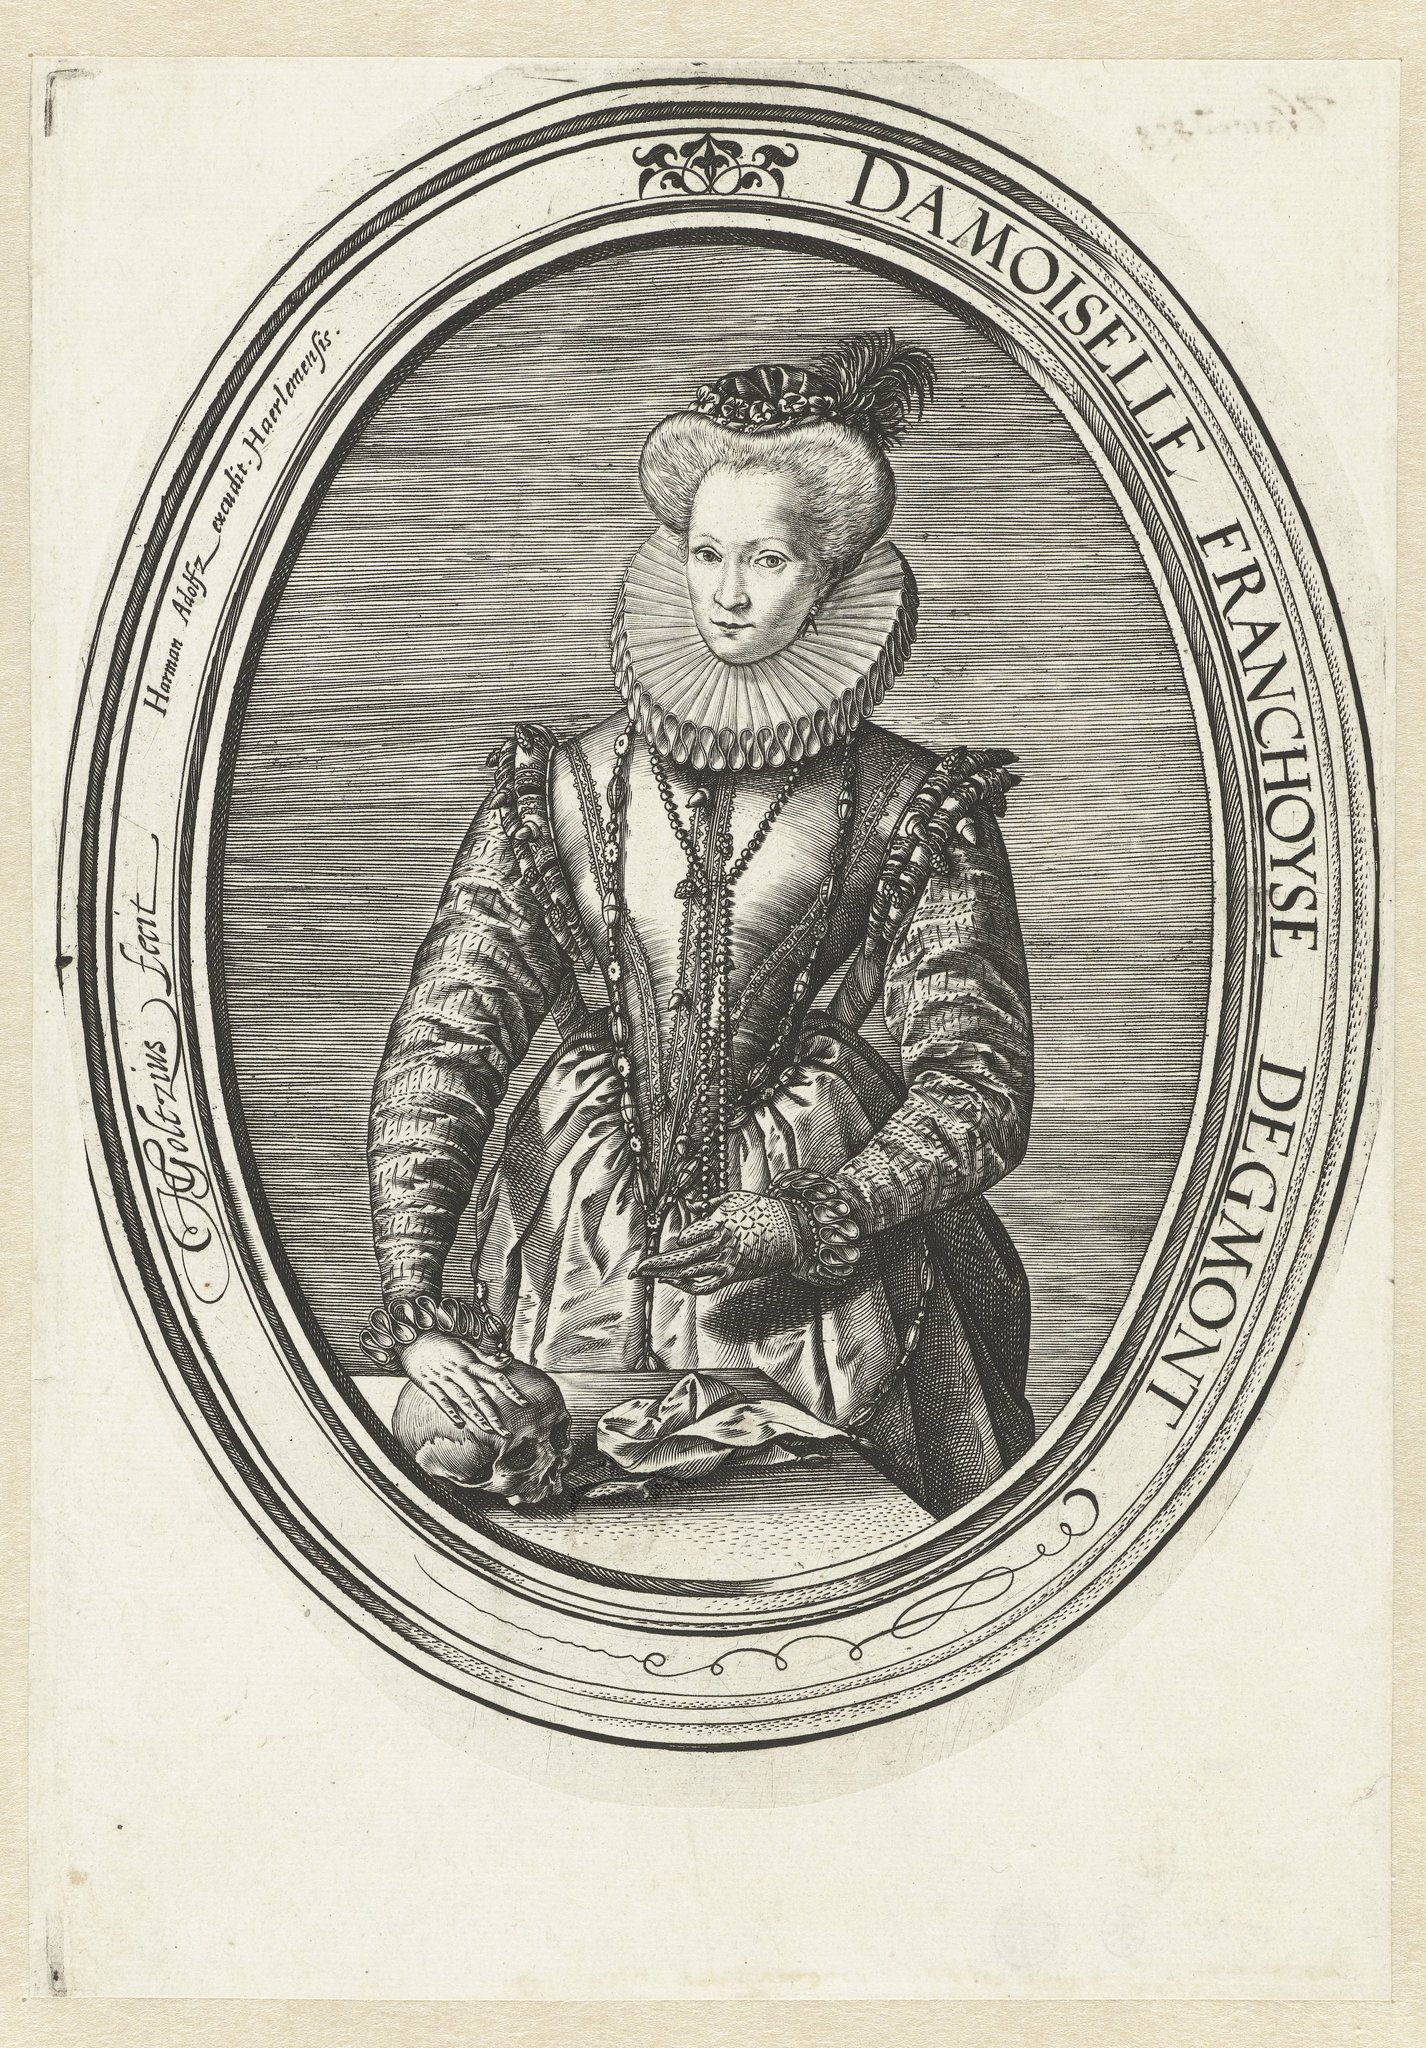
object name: print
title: Portret van Françoise van Egmond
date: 1580-1600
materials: paper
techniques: engraving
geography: haarlem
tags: historical persons - bb - woman, head-gear: hat (+ women's clothes), neck-gear ~ clothing (with name) (+ women's clothes), gloves, mittens, etc. (+ women's clothes), sleeves: cuffs (+ women's clothes), dress, gown (+ women's clothes), skull as symbol of 'vanitas', sleeves (+ women's clothes), necklace (+ women's clothes)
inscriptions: mark: ‘L.1494.’, mark: ‘ri’, mark: ‘L.2760.’, mark: ‘L.2228’, mark: ‘L.151.’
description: Francoise van Egmond is gekleed in japon met dubbele schouderrollen* versierd met knopjes* en brede molensteenkraag*. Aan de mouwen geplooide manchetten*. Op het opgekamde haar* een toque*. Om de hals verschillende kettingen*; aan de linkerhand een handschoen* met splitten.